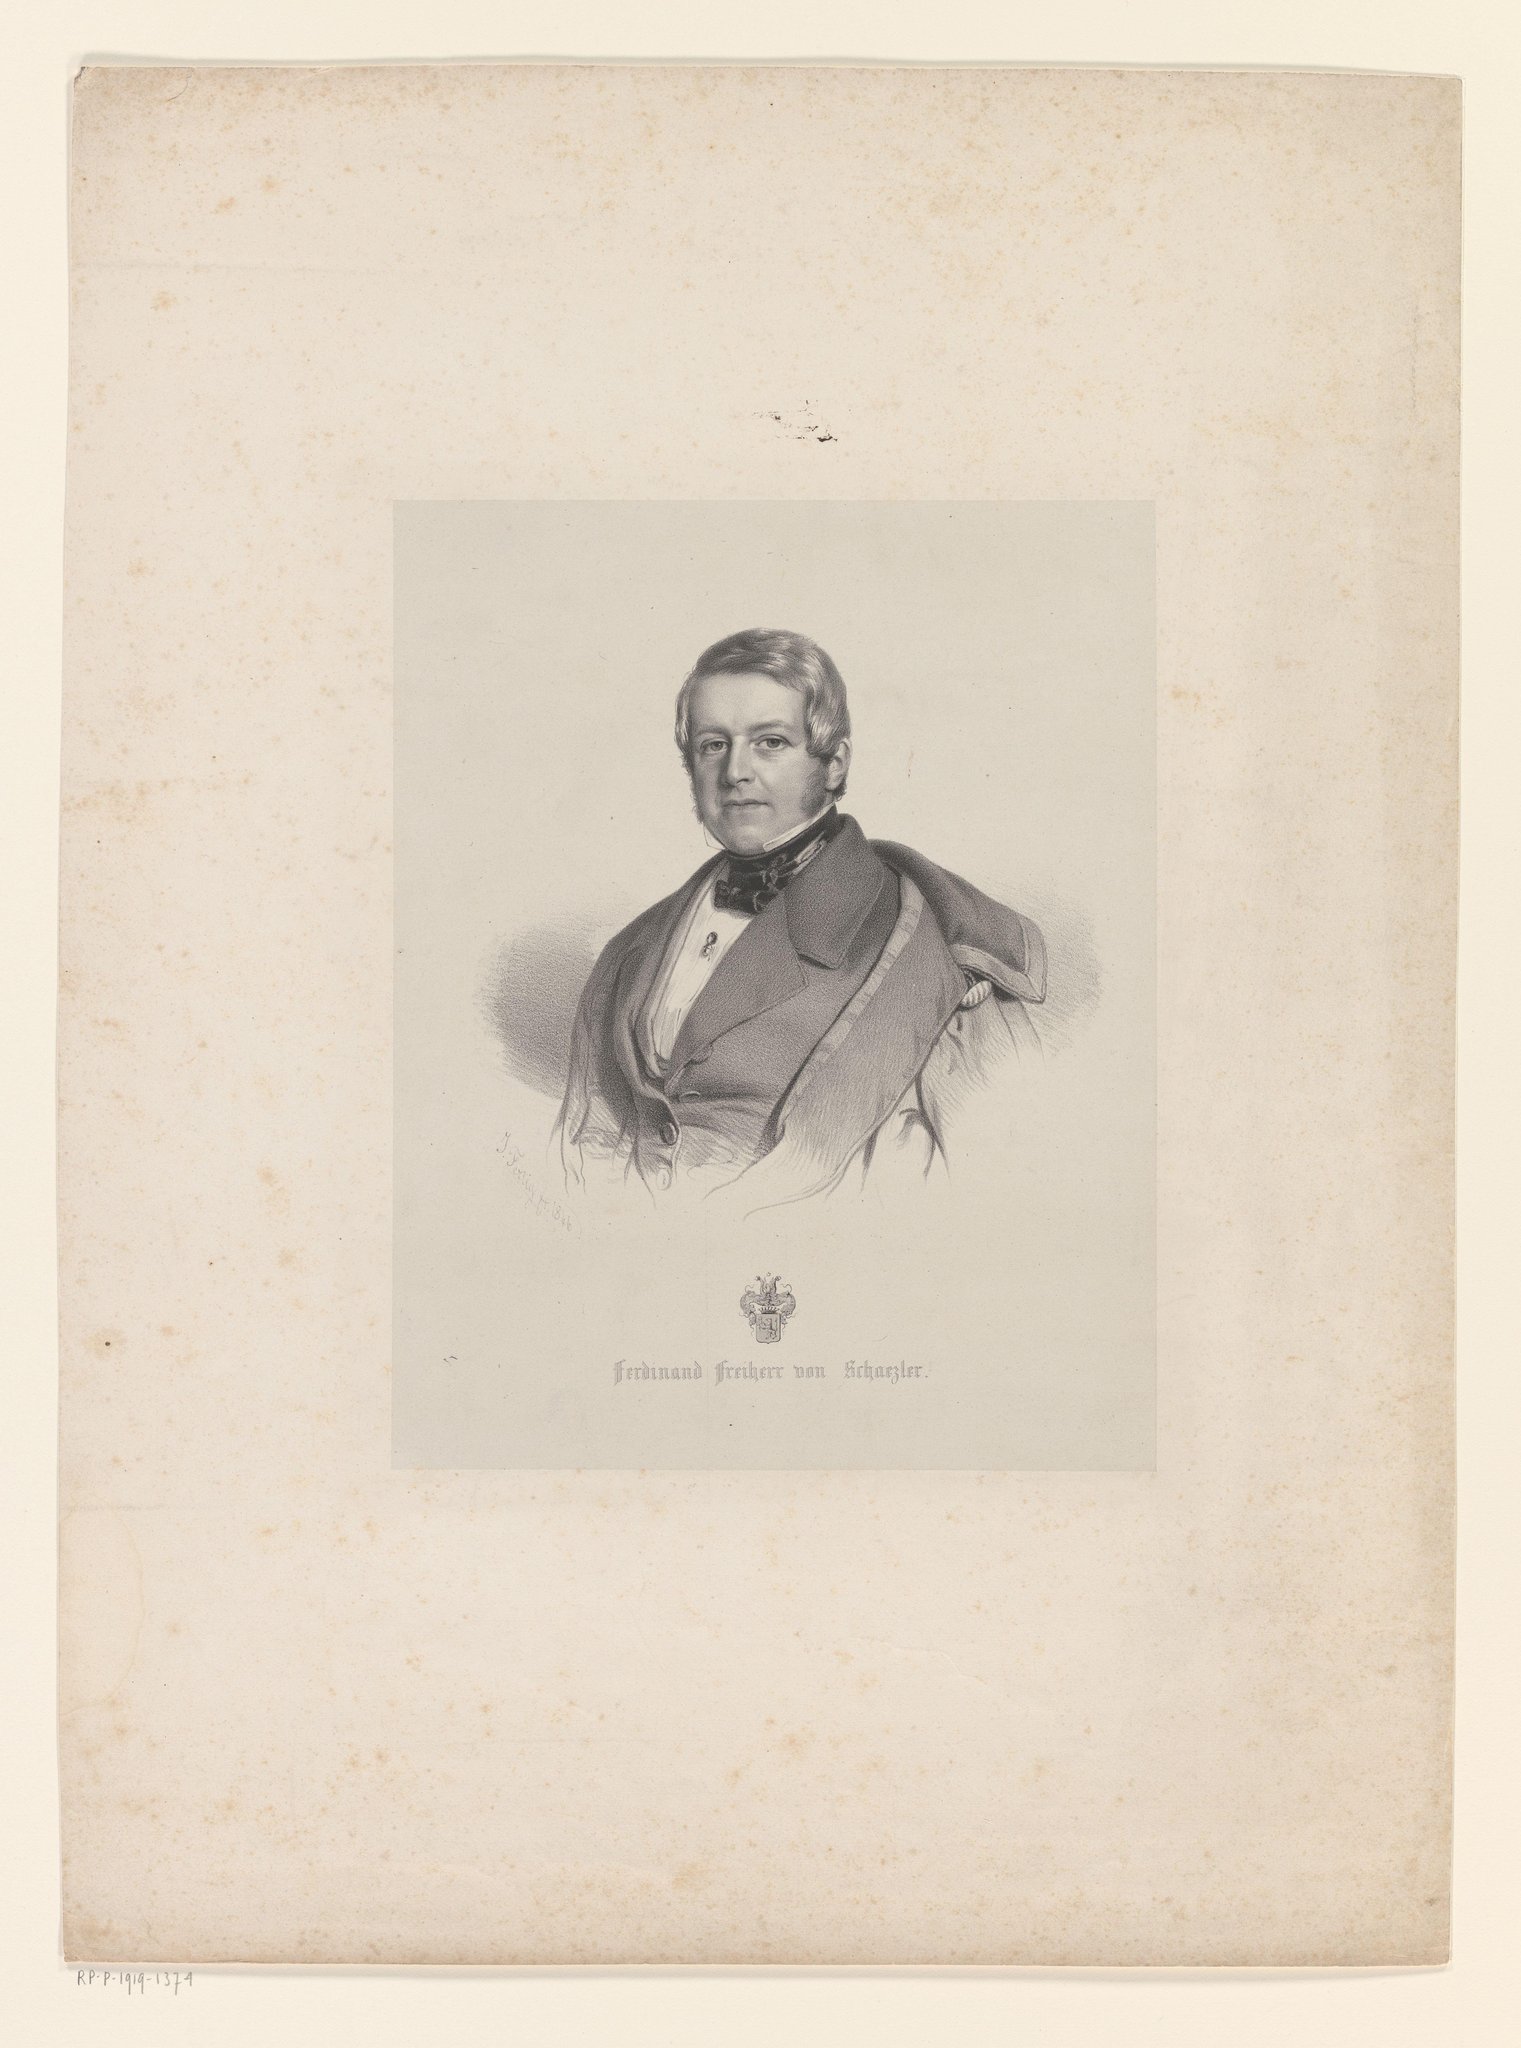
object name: print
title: Ferdinand Freiherr von Schaezler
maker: ignaz fertig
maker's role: print maker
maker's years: 1809-1858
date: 1846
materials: paper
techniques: lithograph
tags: adult man, historical persons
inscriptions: collector's mark: Lugt 2228